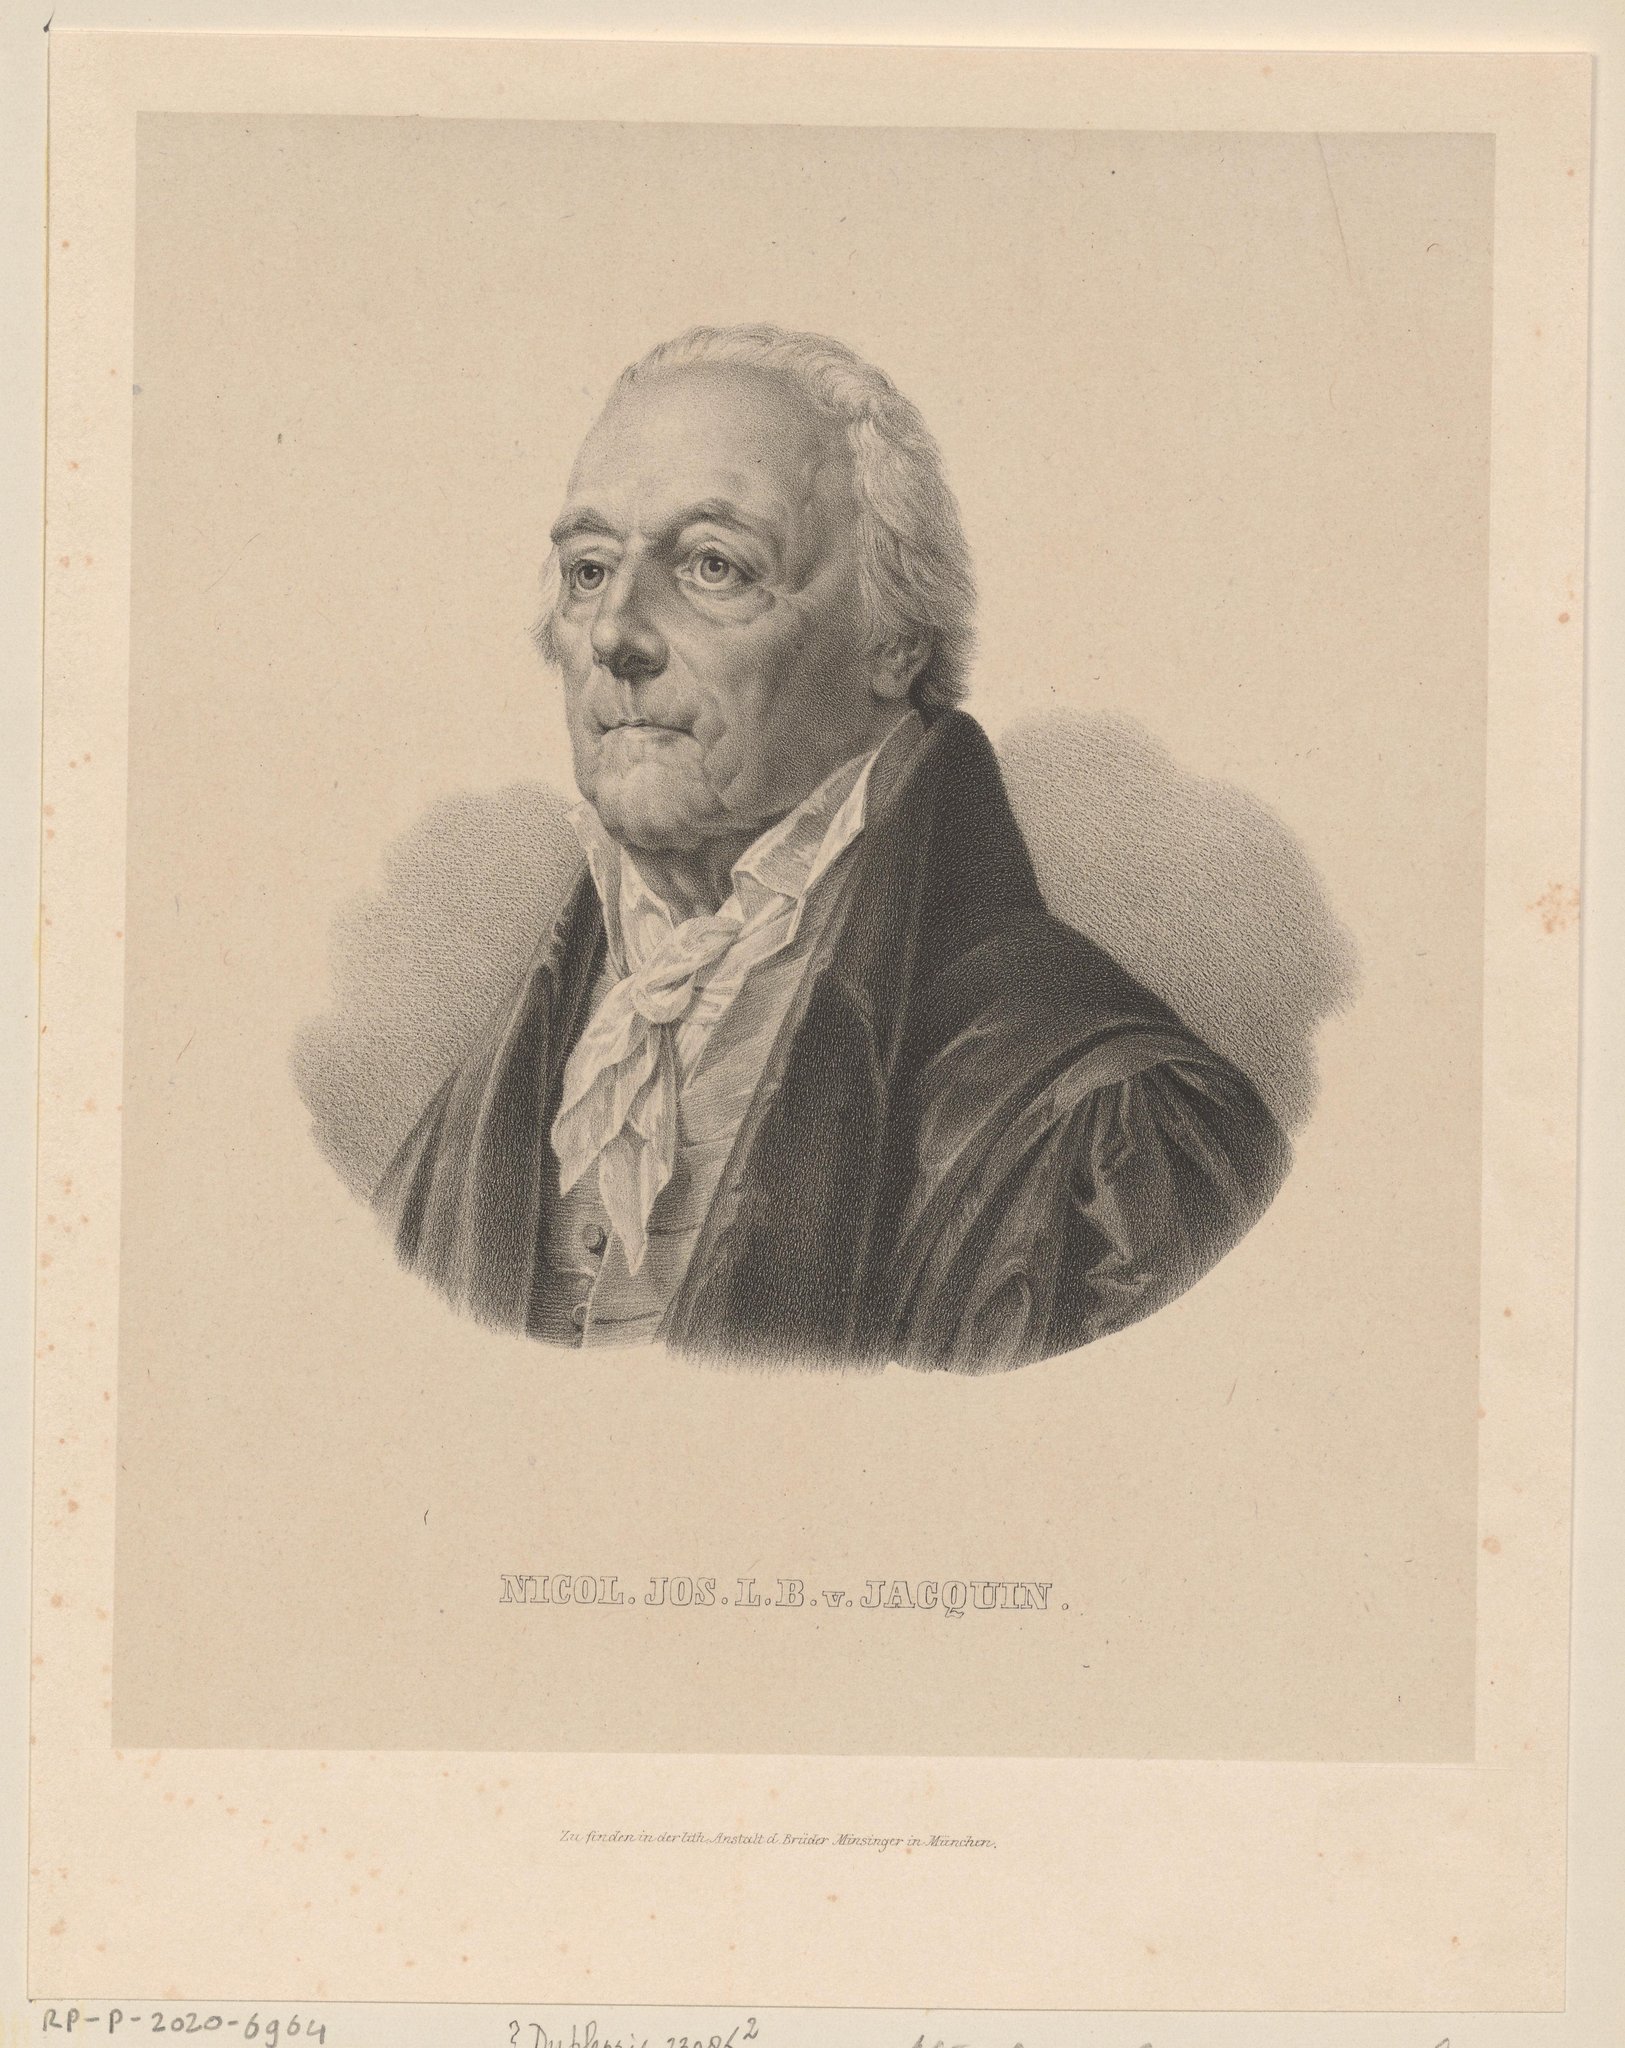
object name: print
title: Portret van baron Nikolaus Joseph von Jacquin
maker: Anonymous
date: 1840-1899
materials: paper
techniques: lithograph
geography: munich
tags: leiden, vienna, historical persons, professor